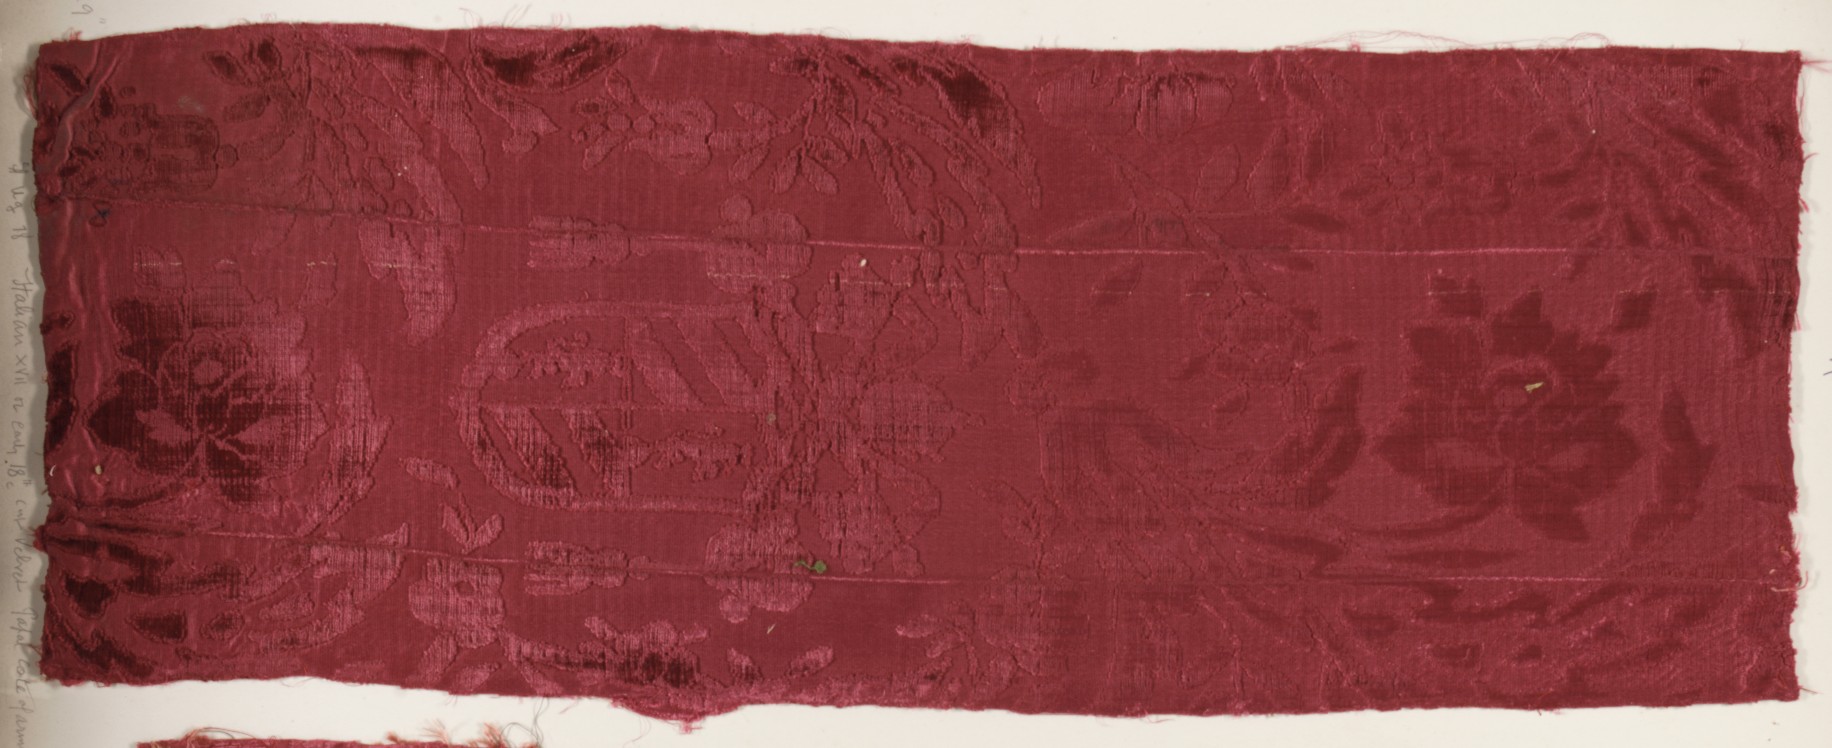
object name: fragment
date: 1601-1733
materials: silk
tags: flowers,leaves